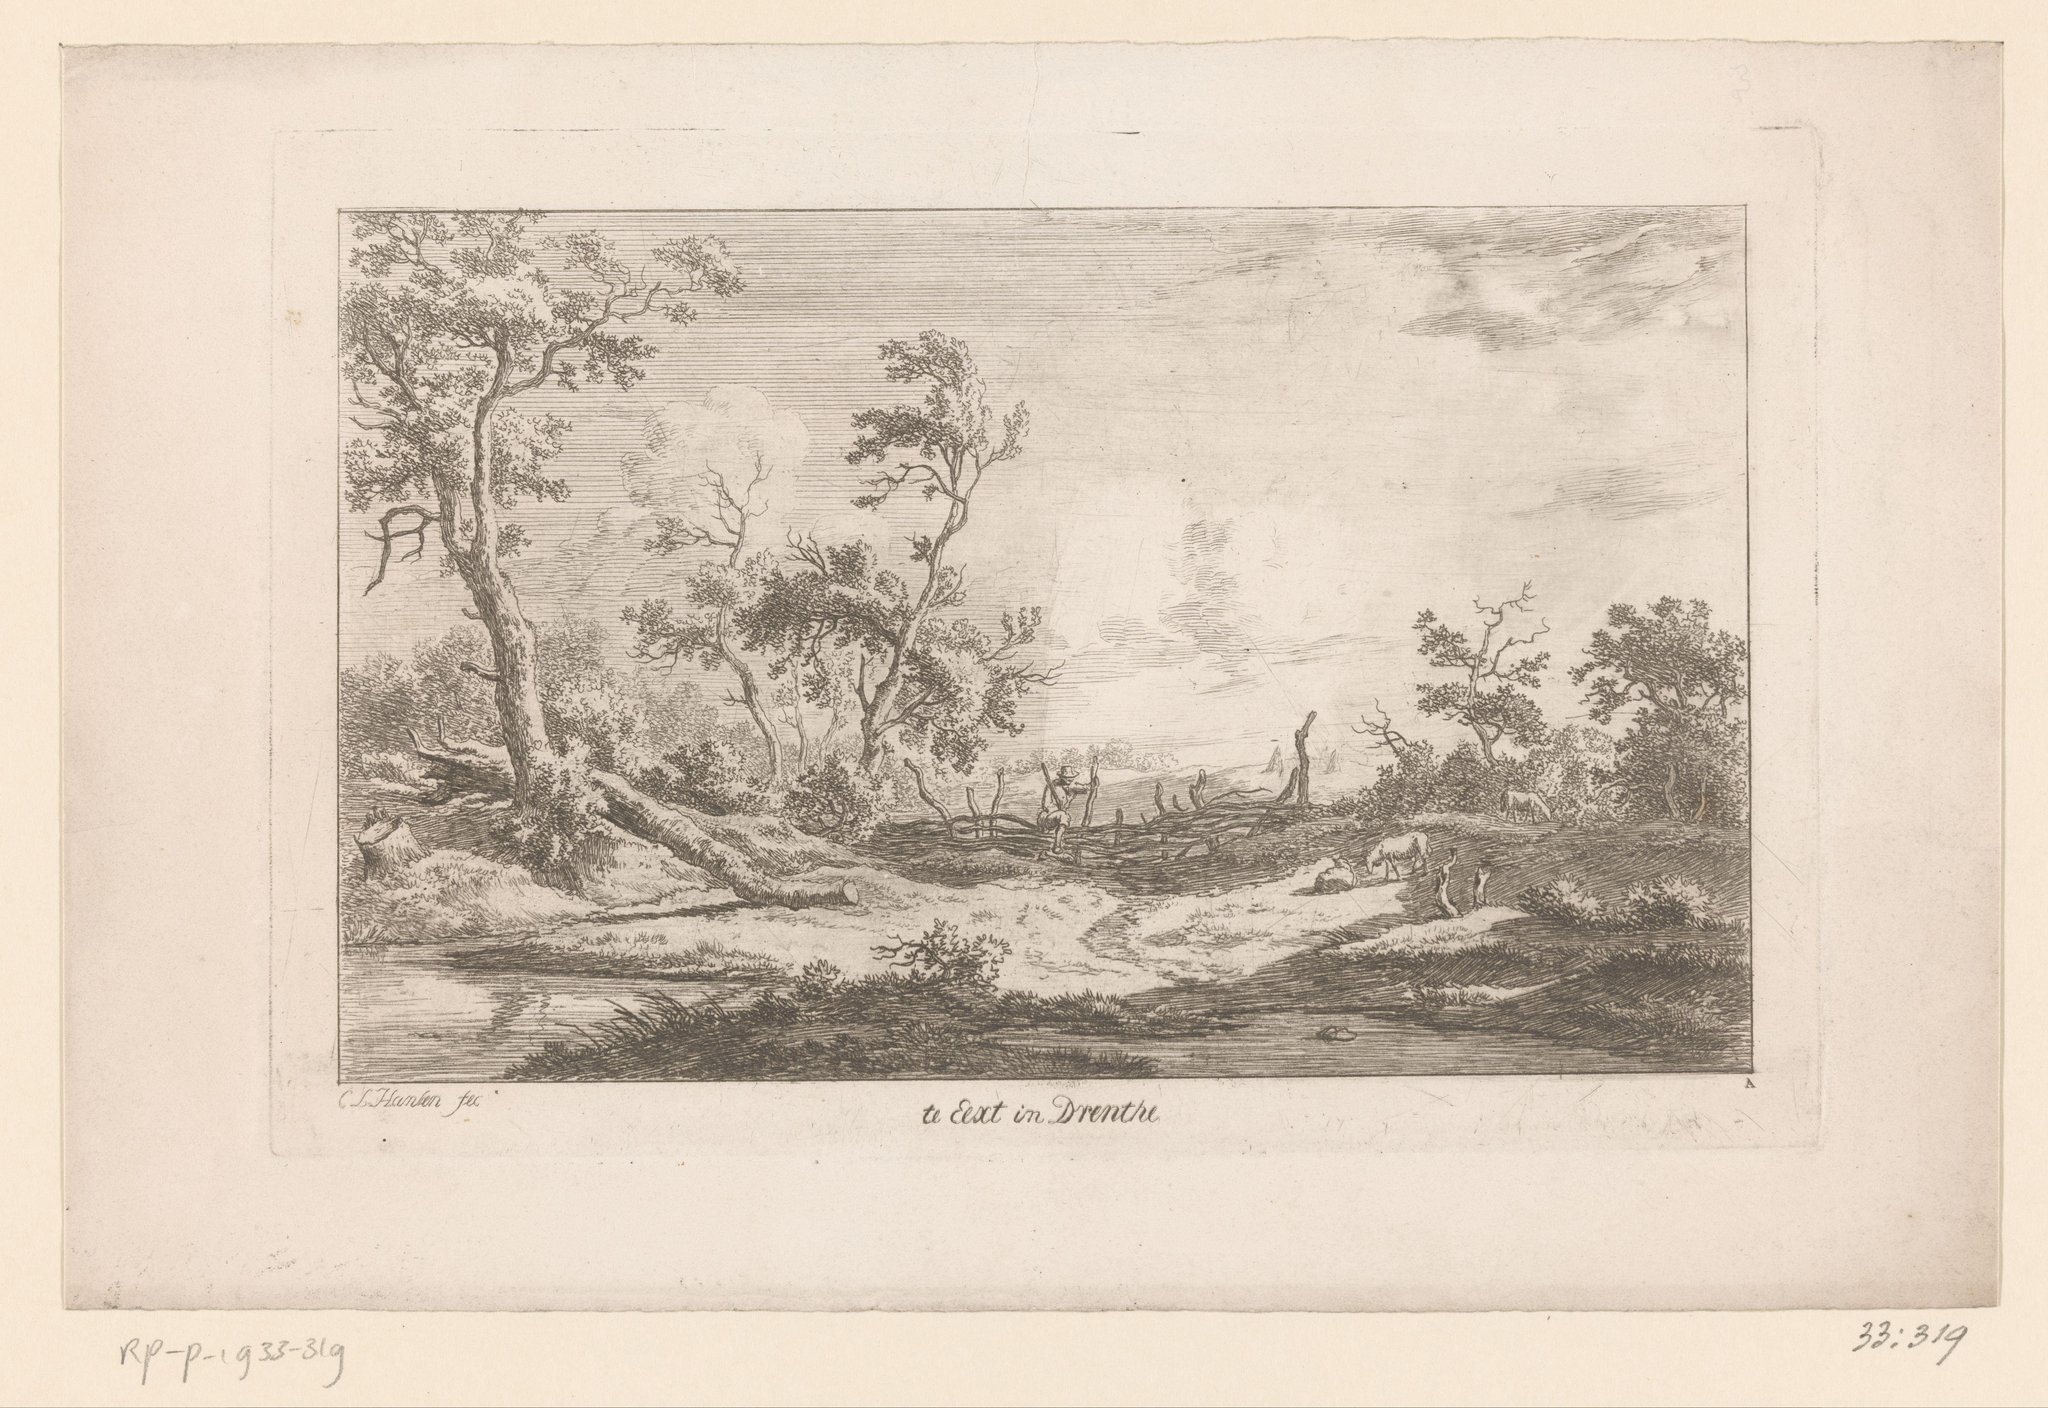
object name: print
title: Landschap bij een oever te Eext in Drenthe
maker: carel lodewijk hansen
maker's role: draughtsman, painter, print maker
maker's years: 1765-1840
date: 1775-1840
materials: paper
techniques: etching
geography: netherlands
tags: sheep, river bank (+ landscape with figures, staffage)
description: Onderdeel van een serie landschappen, rechtsonder gemerkt in hoofdletters A-F. Deze prent is gemerkt: A.